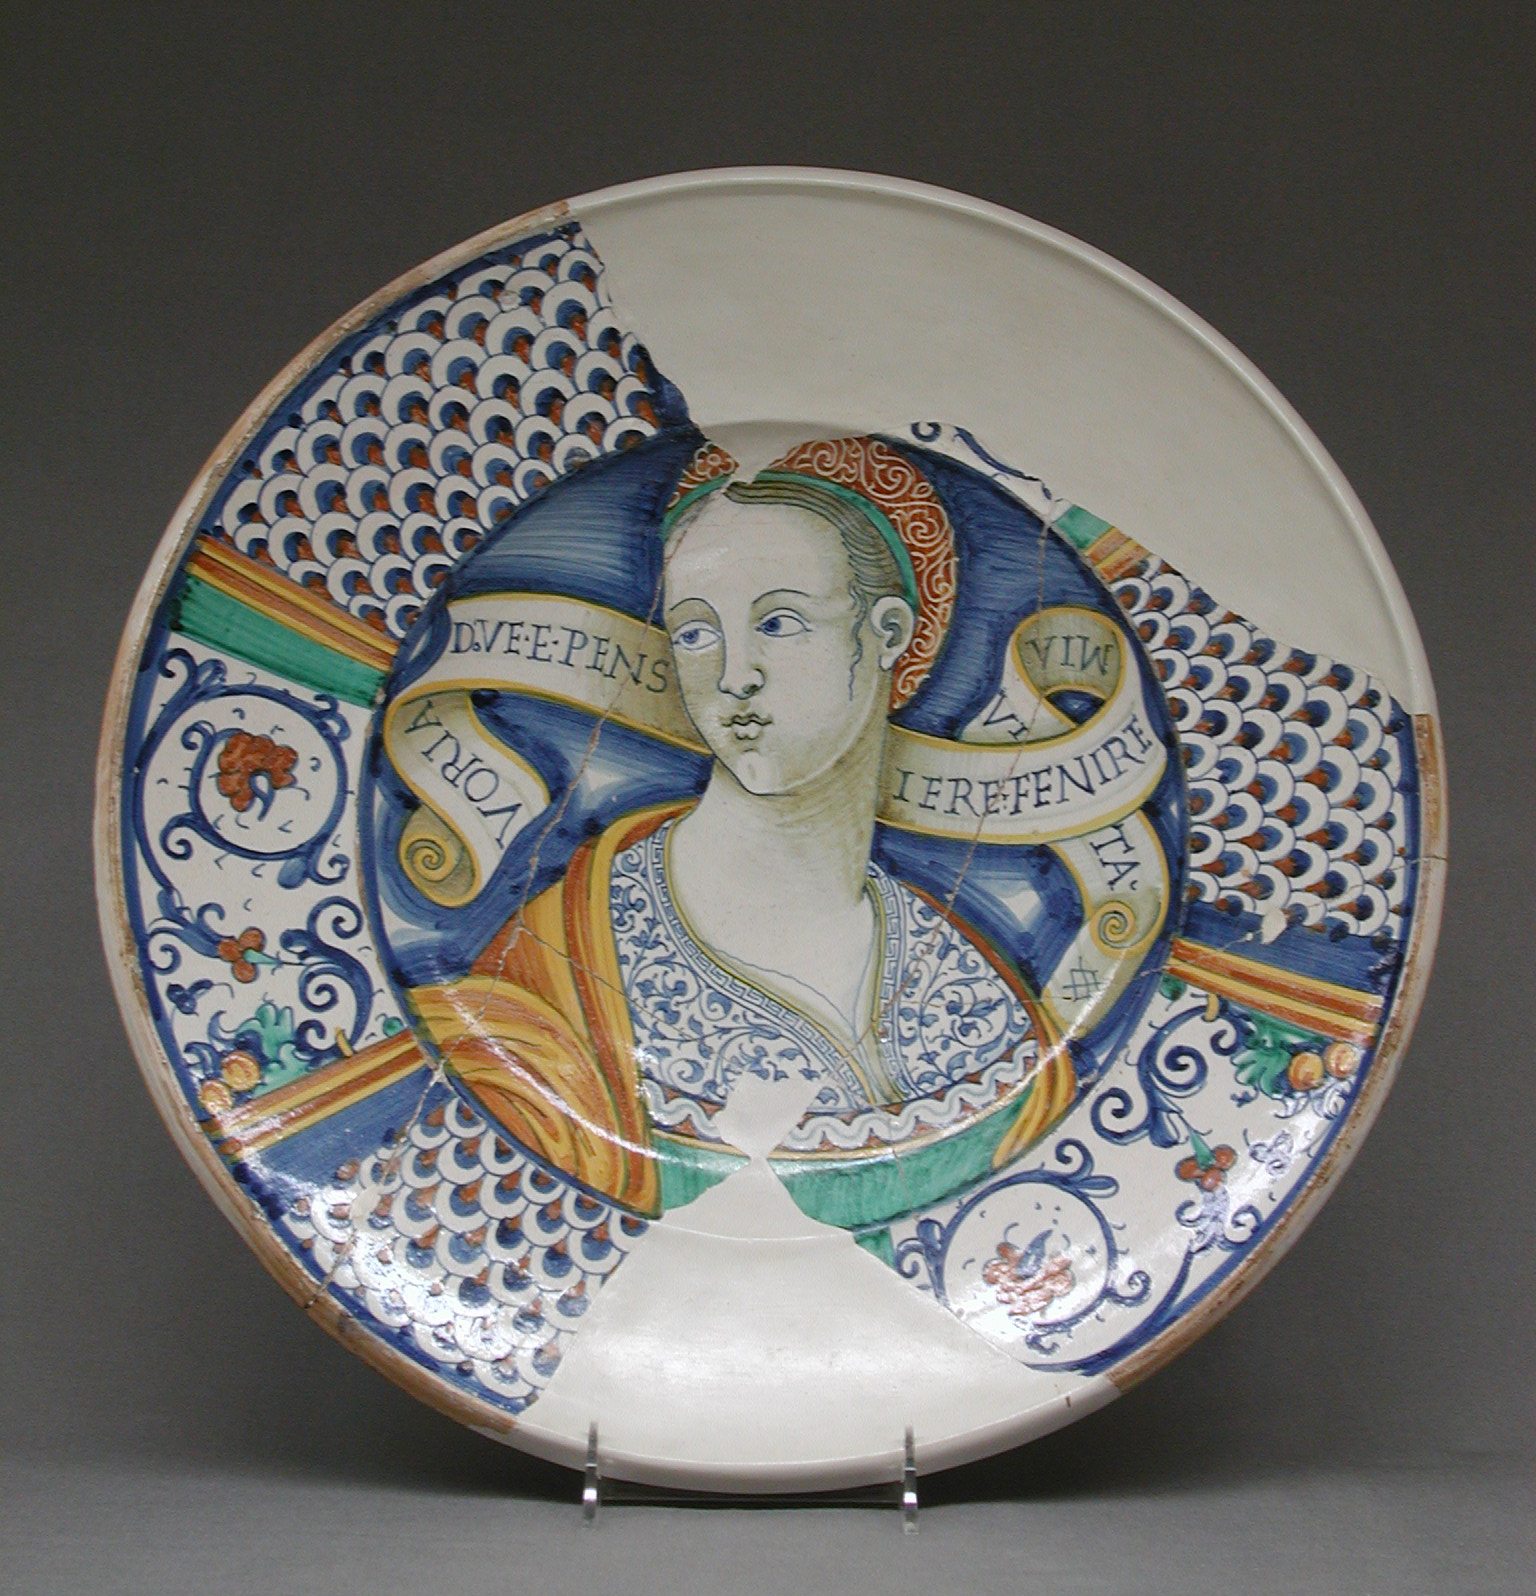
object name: plateau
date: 1540-1545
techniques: maiolica, glazing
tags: women